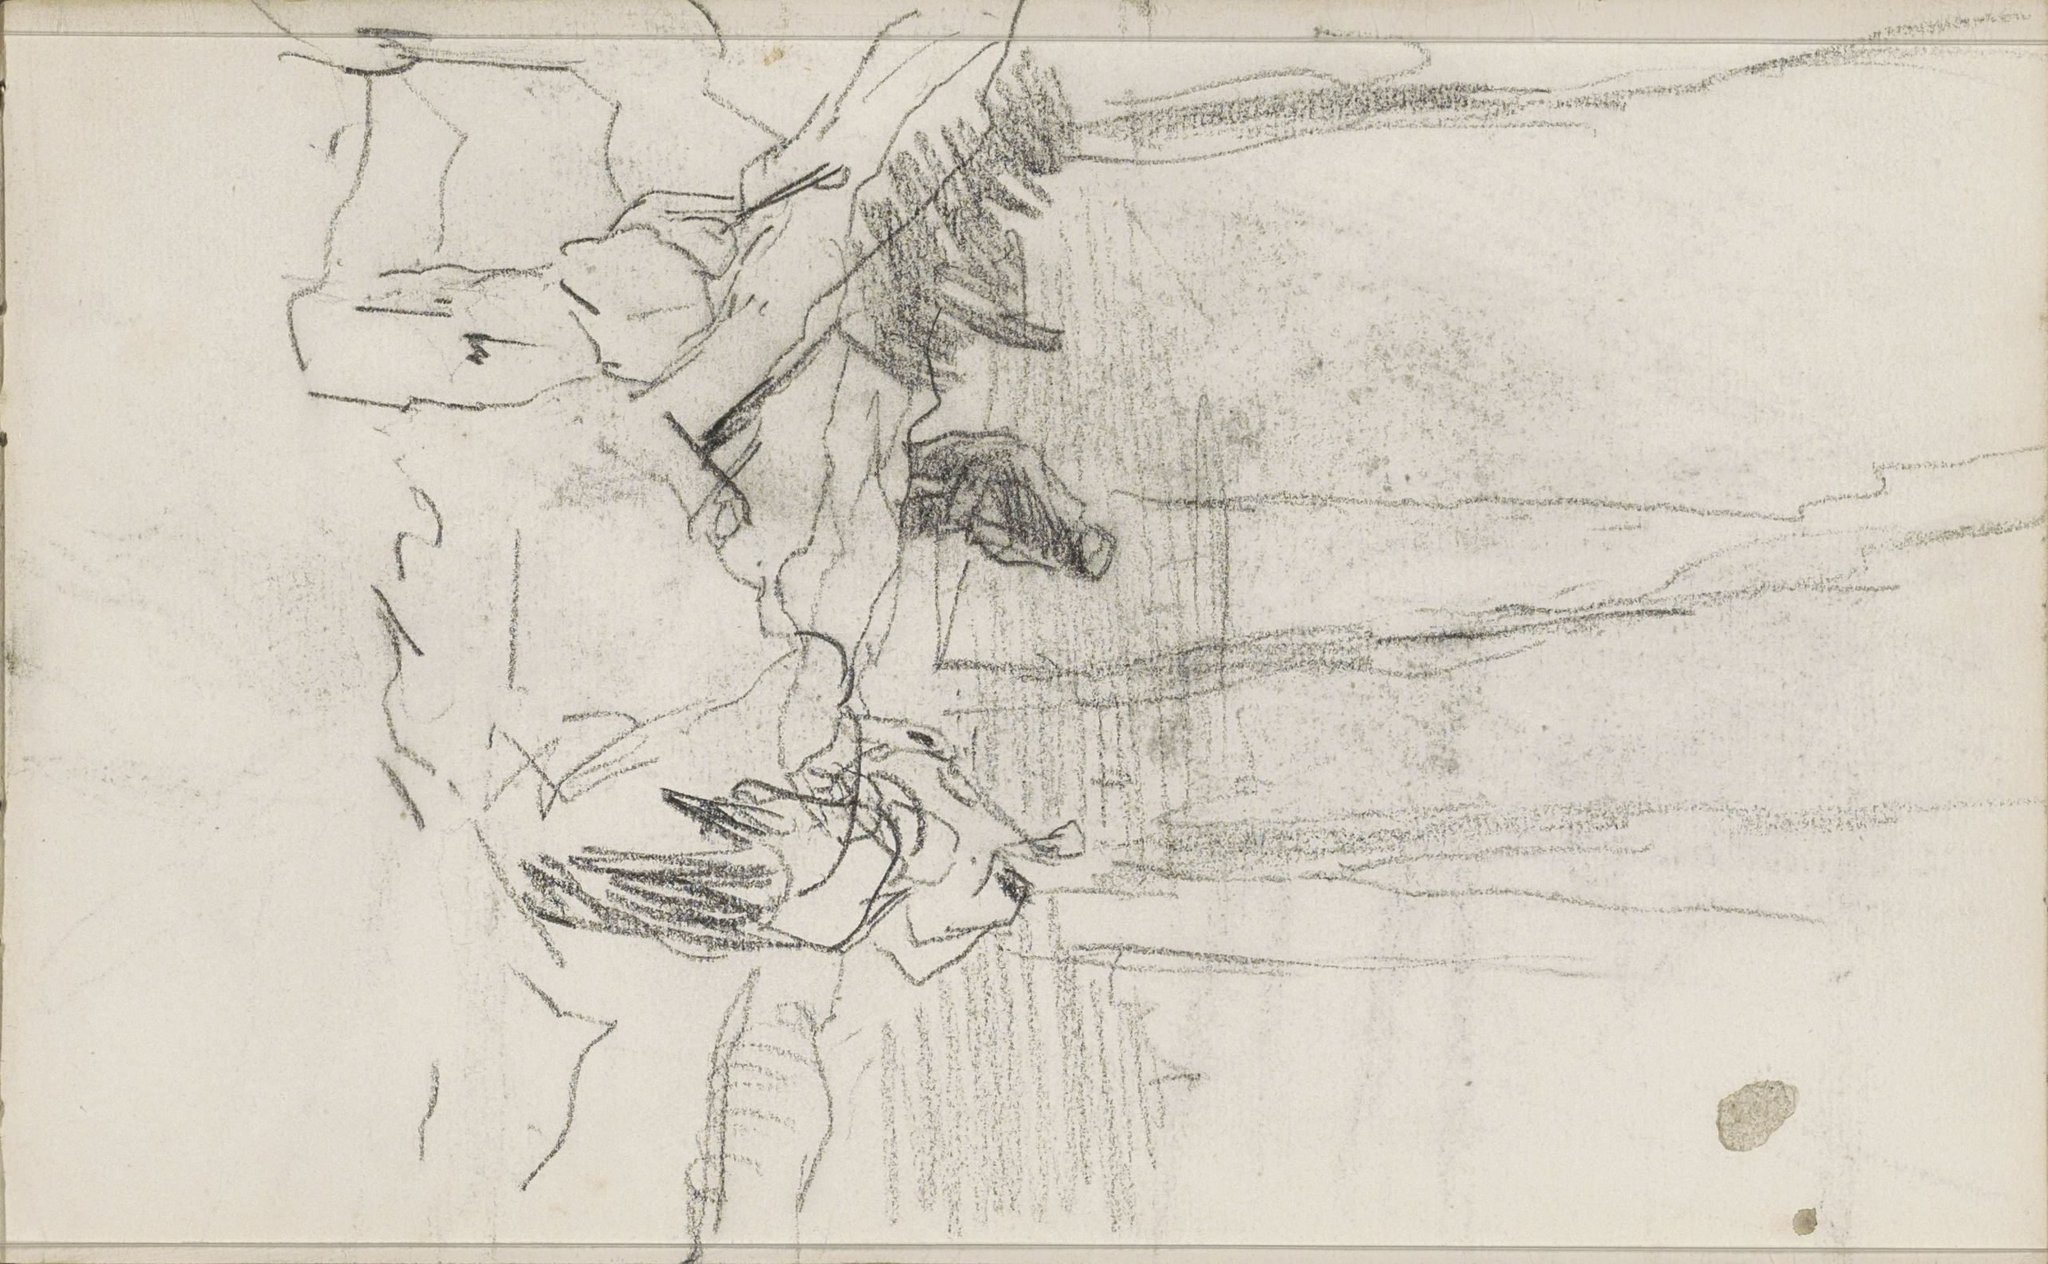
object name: sketchbook leaf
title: Houthakkers bij een omgehakte boom in een bos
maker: anton mauve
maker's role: draughtsman, painter, print maker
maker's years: 1838-1888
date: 1848-1888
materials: chalk, paper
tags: woodcutting, woodcutter ~ forestry, trees (+ stem, trunk)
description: Blad 22 recto uit een schetsboek met 41 bladen.